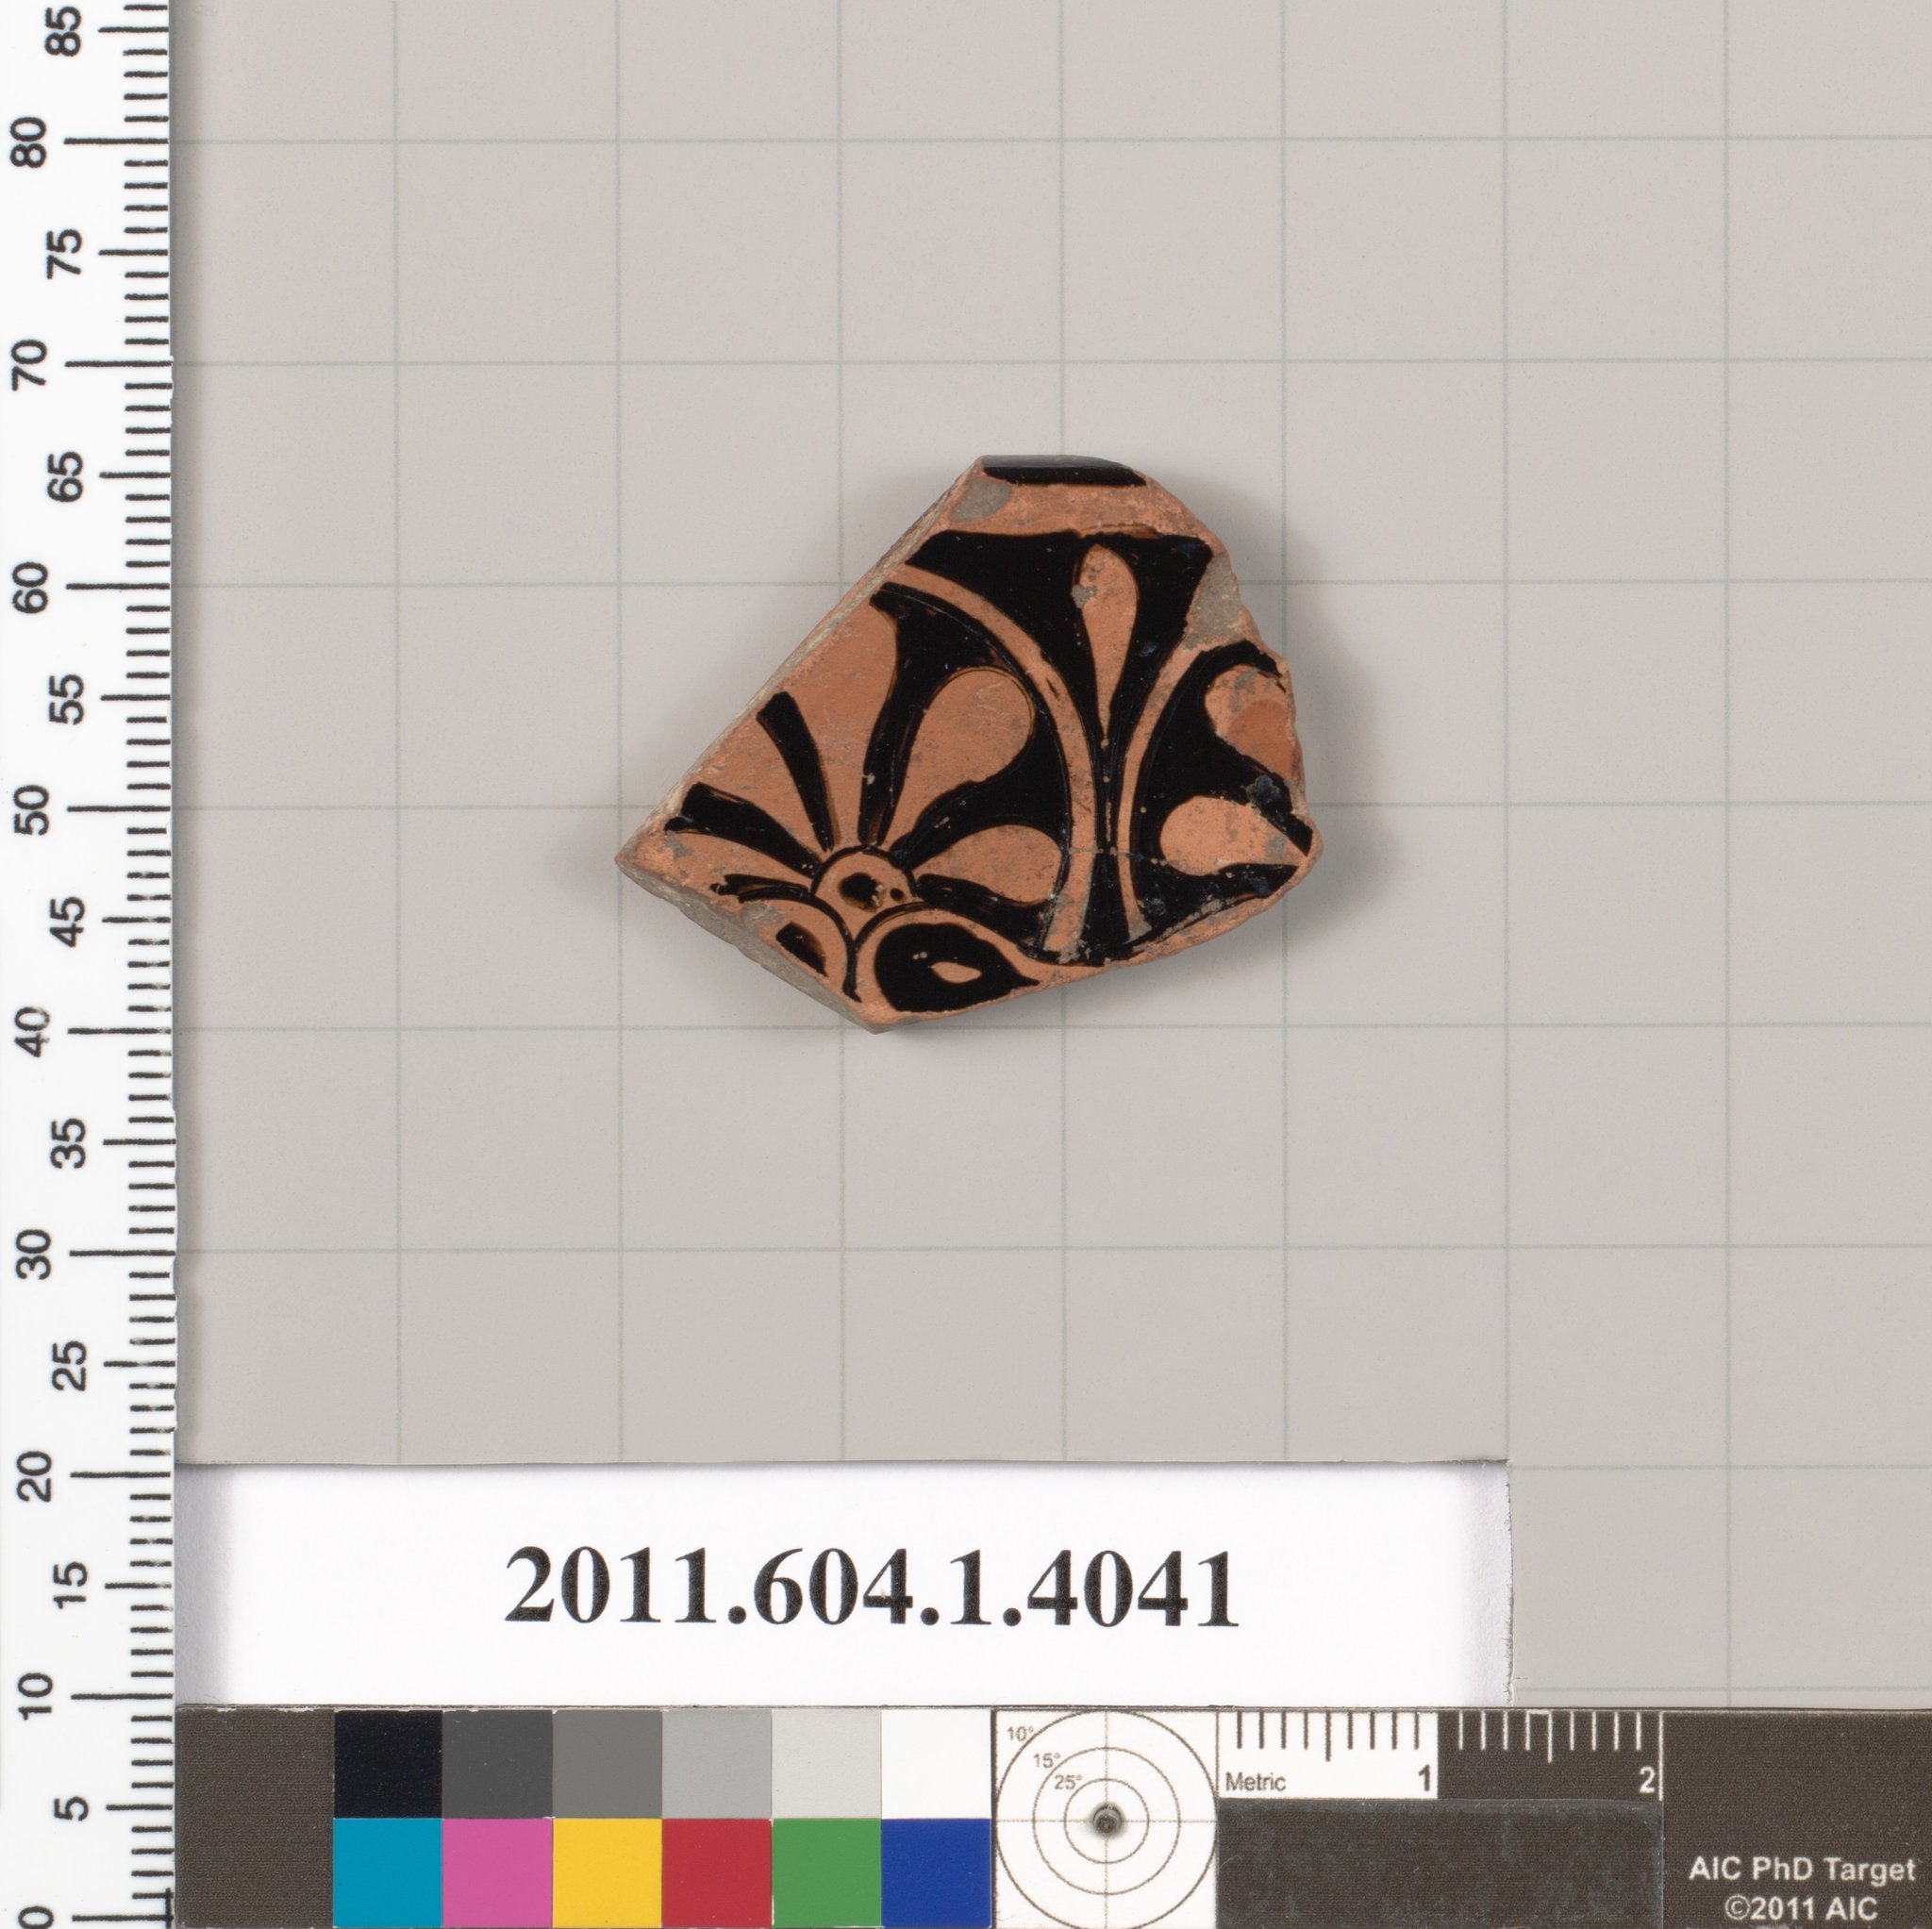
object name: kylix fragment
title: Terracotta fragment of a kylix (drinking cup)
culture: greek, attic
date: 534-468 BCE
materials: terracotta